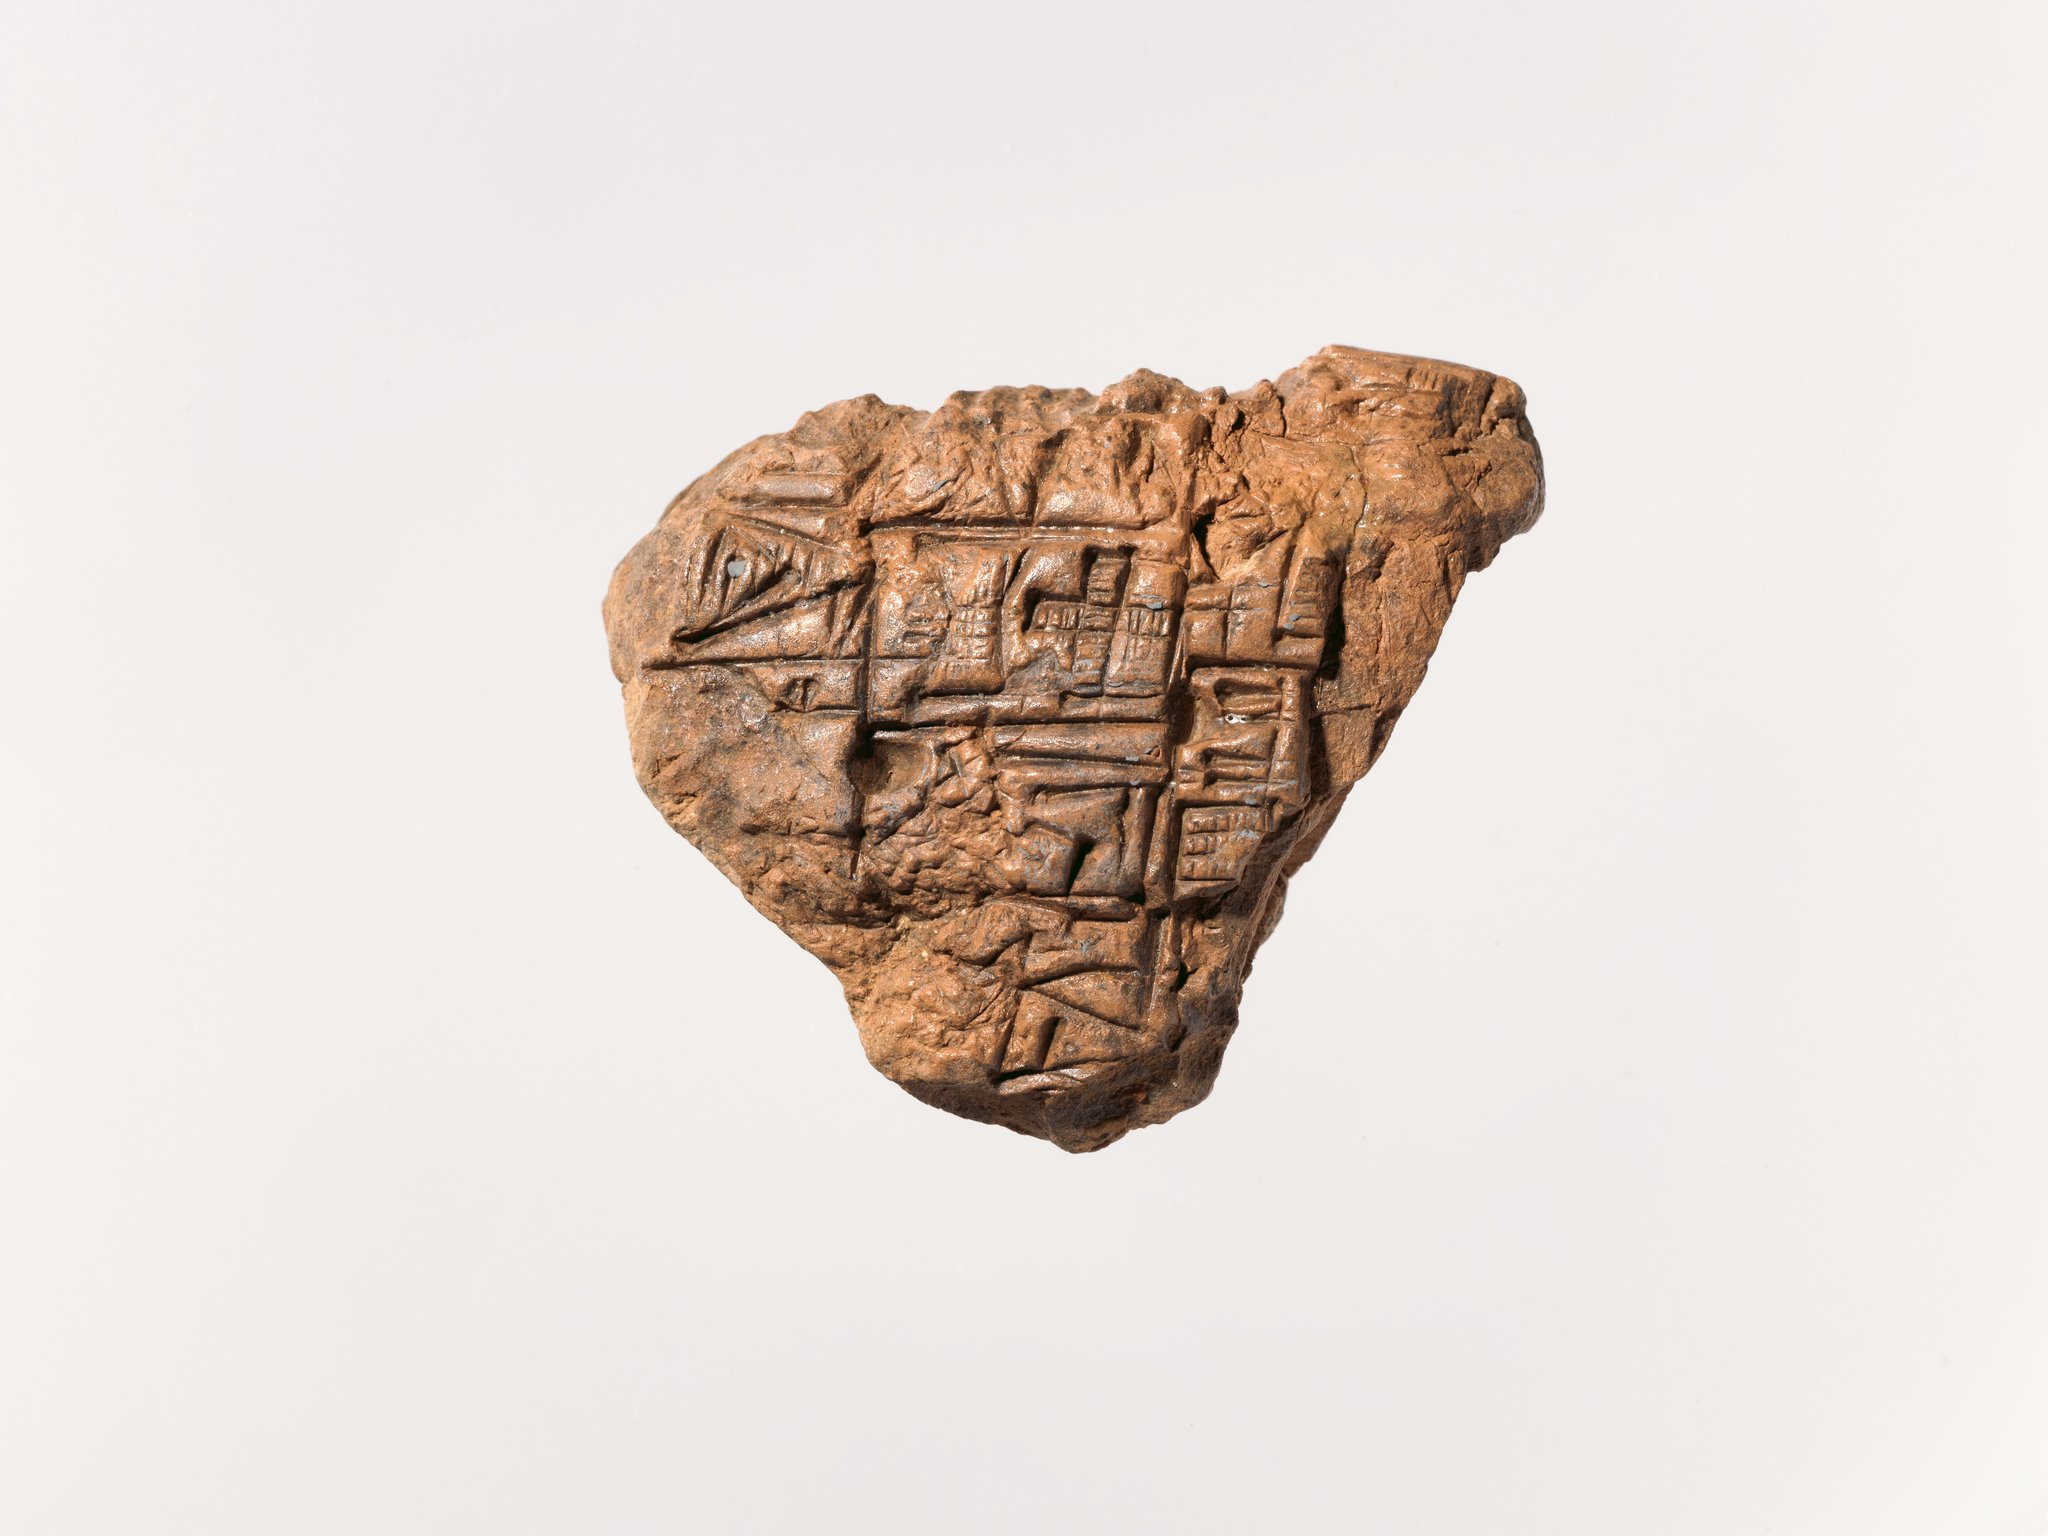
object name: cuneiform tablet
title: Cuneiform tablet: fragment concerning canals (Sum.e)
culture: sumerian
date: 2600-2350 BCE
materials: clay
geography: mesopotamia